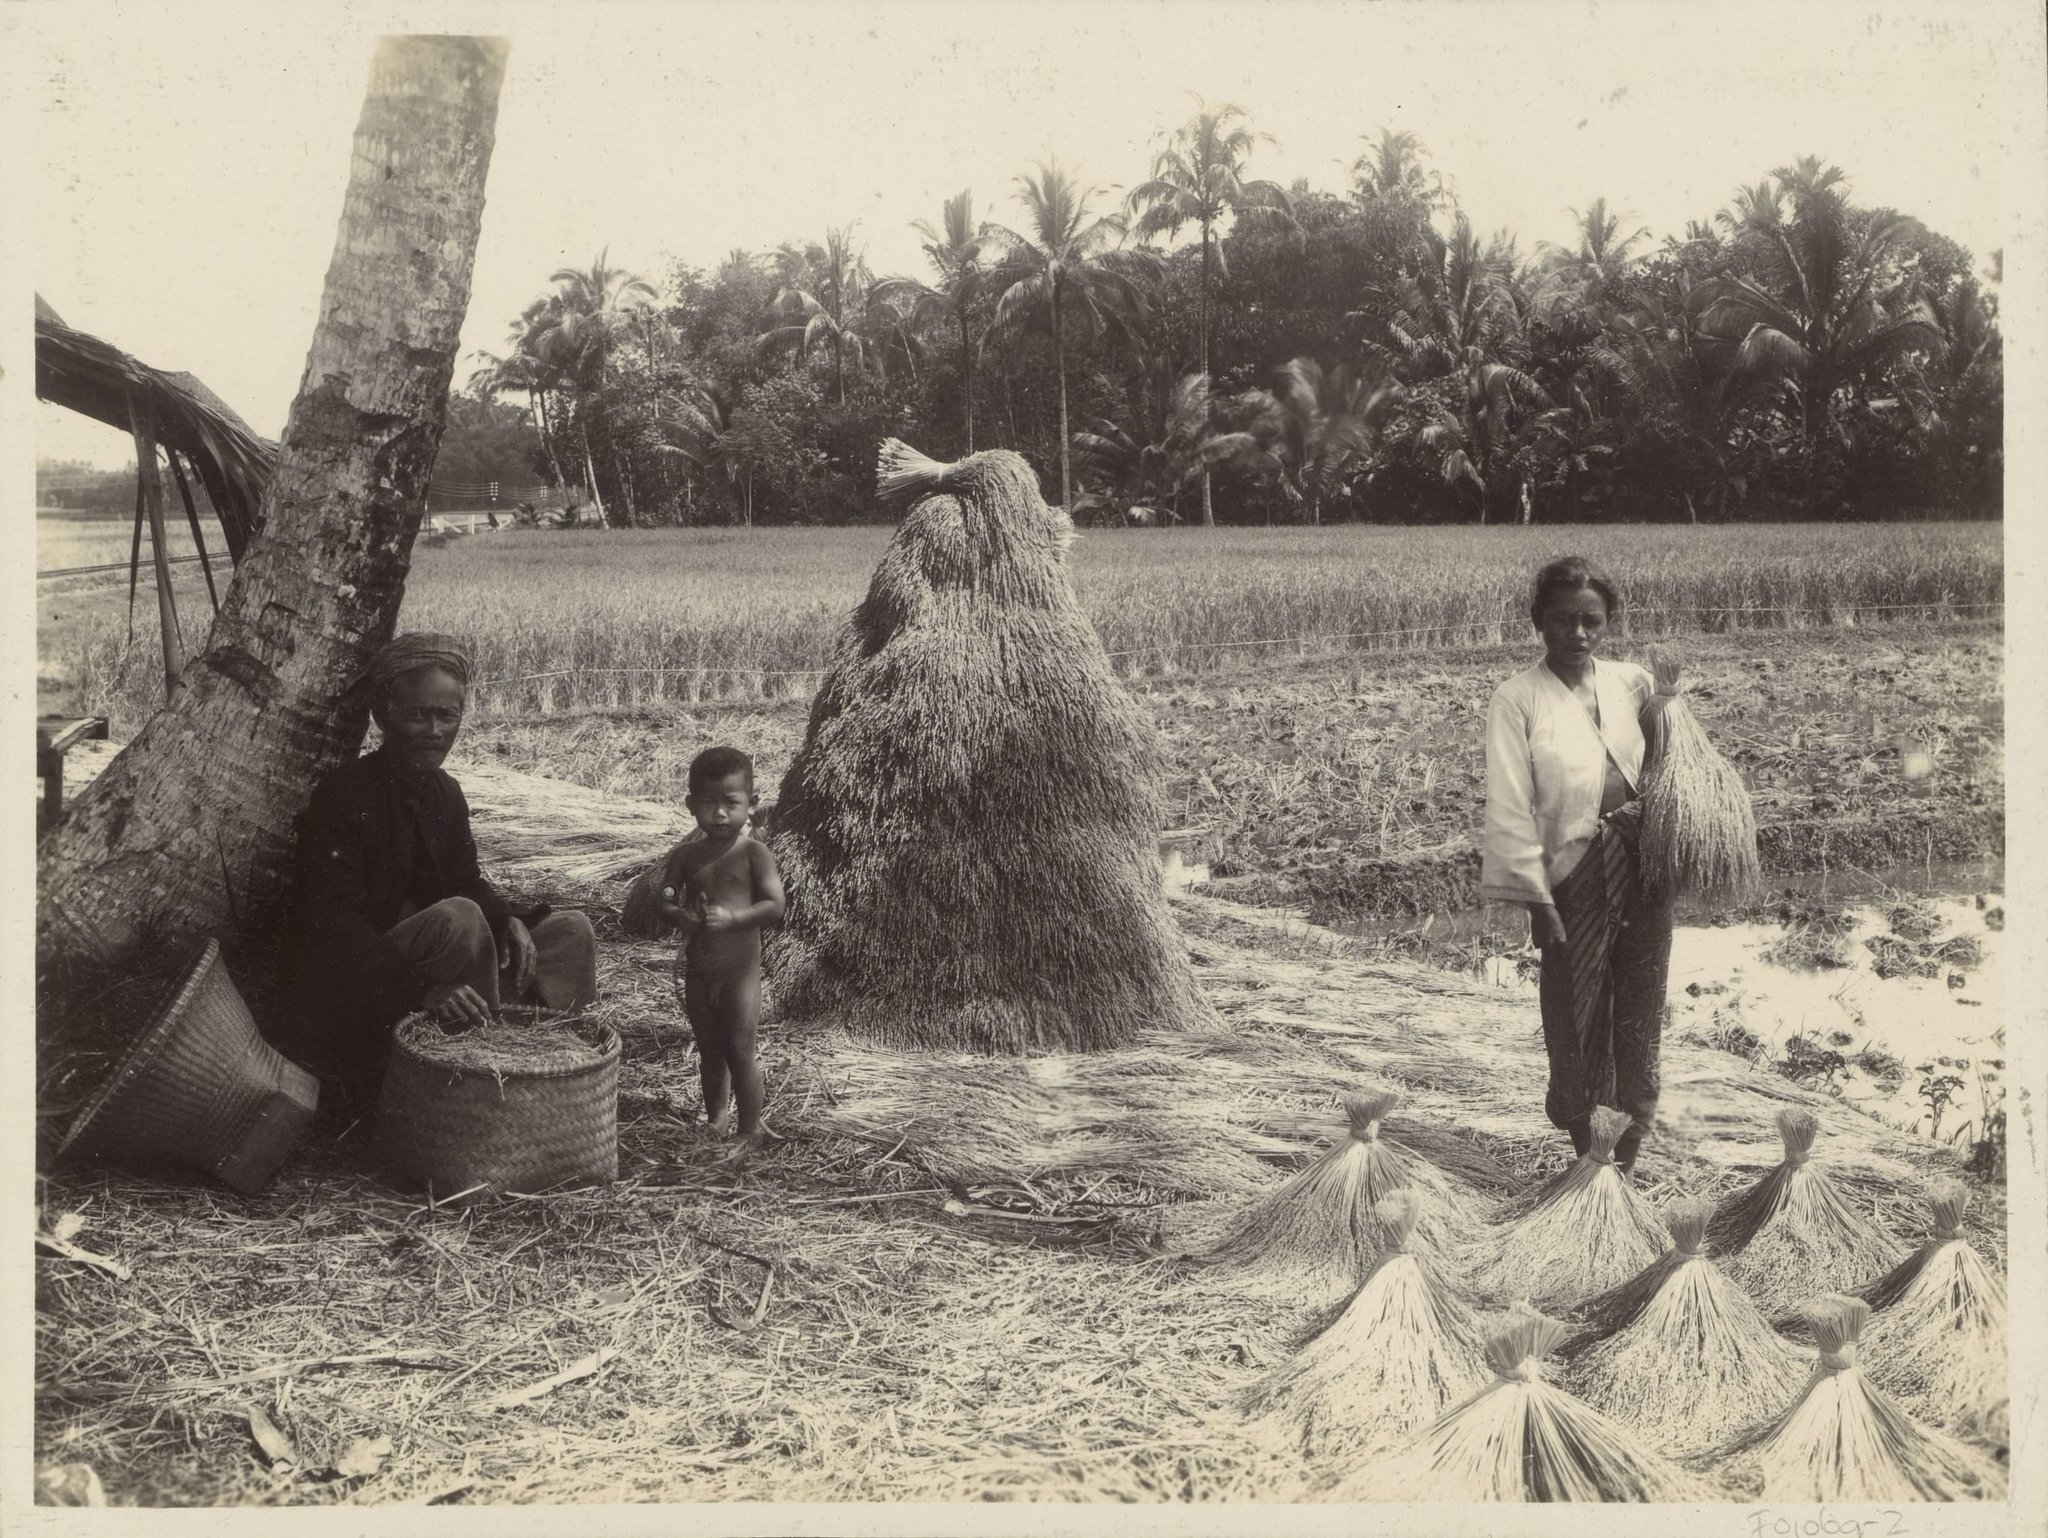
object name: photograph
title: Indische man en vrouw met kind bij de graanoogst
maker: onnes kurkdjian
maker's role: fotograaf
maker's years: 1851-1903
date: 1912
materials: paper, photographic support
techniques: gelatin silver print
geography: dutch east indies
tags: harvest, field filled with a crop, dutch east indies, the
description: Onderdeel van Reisalbum met veertig foto's van Nederlands-Indië.